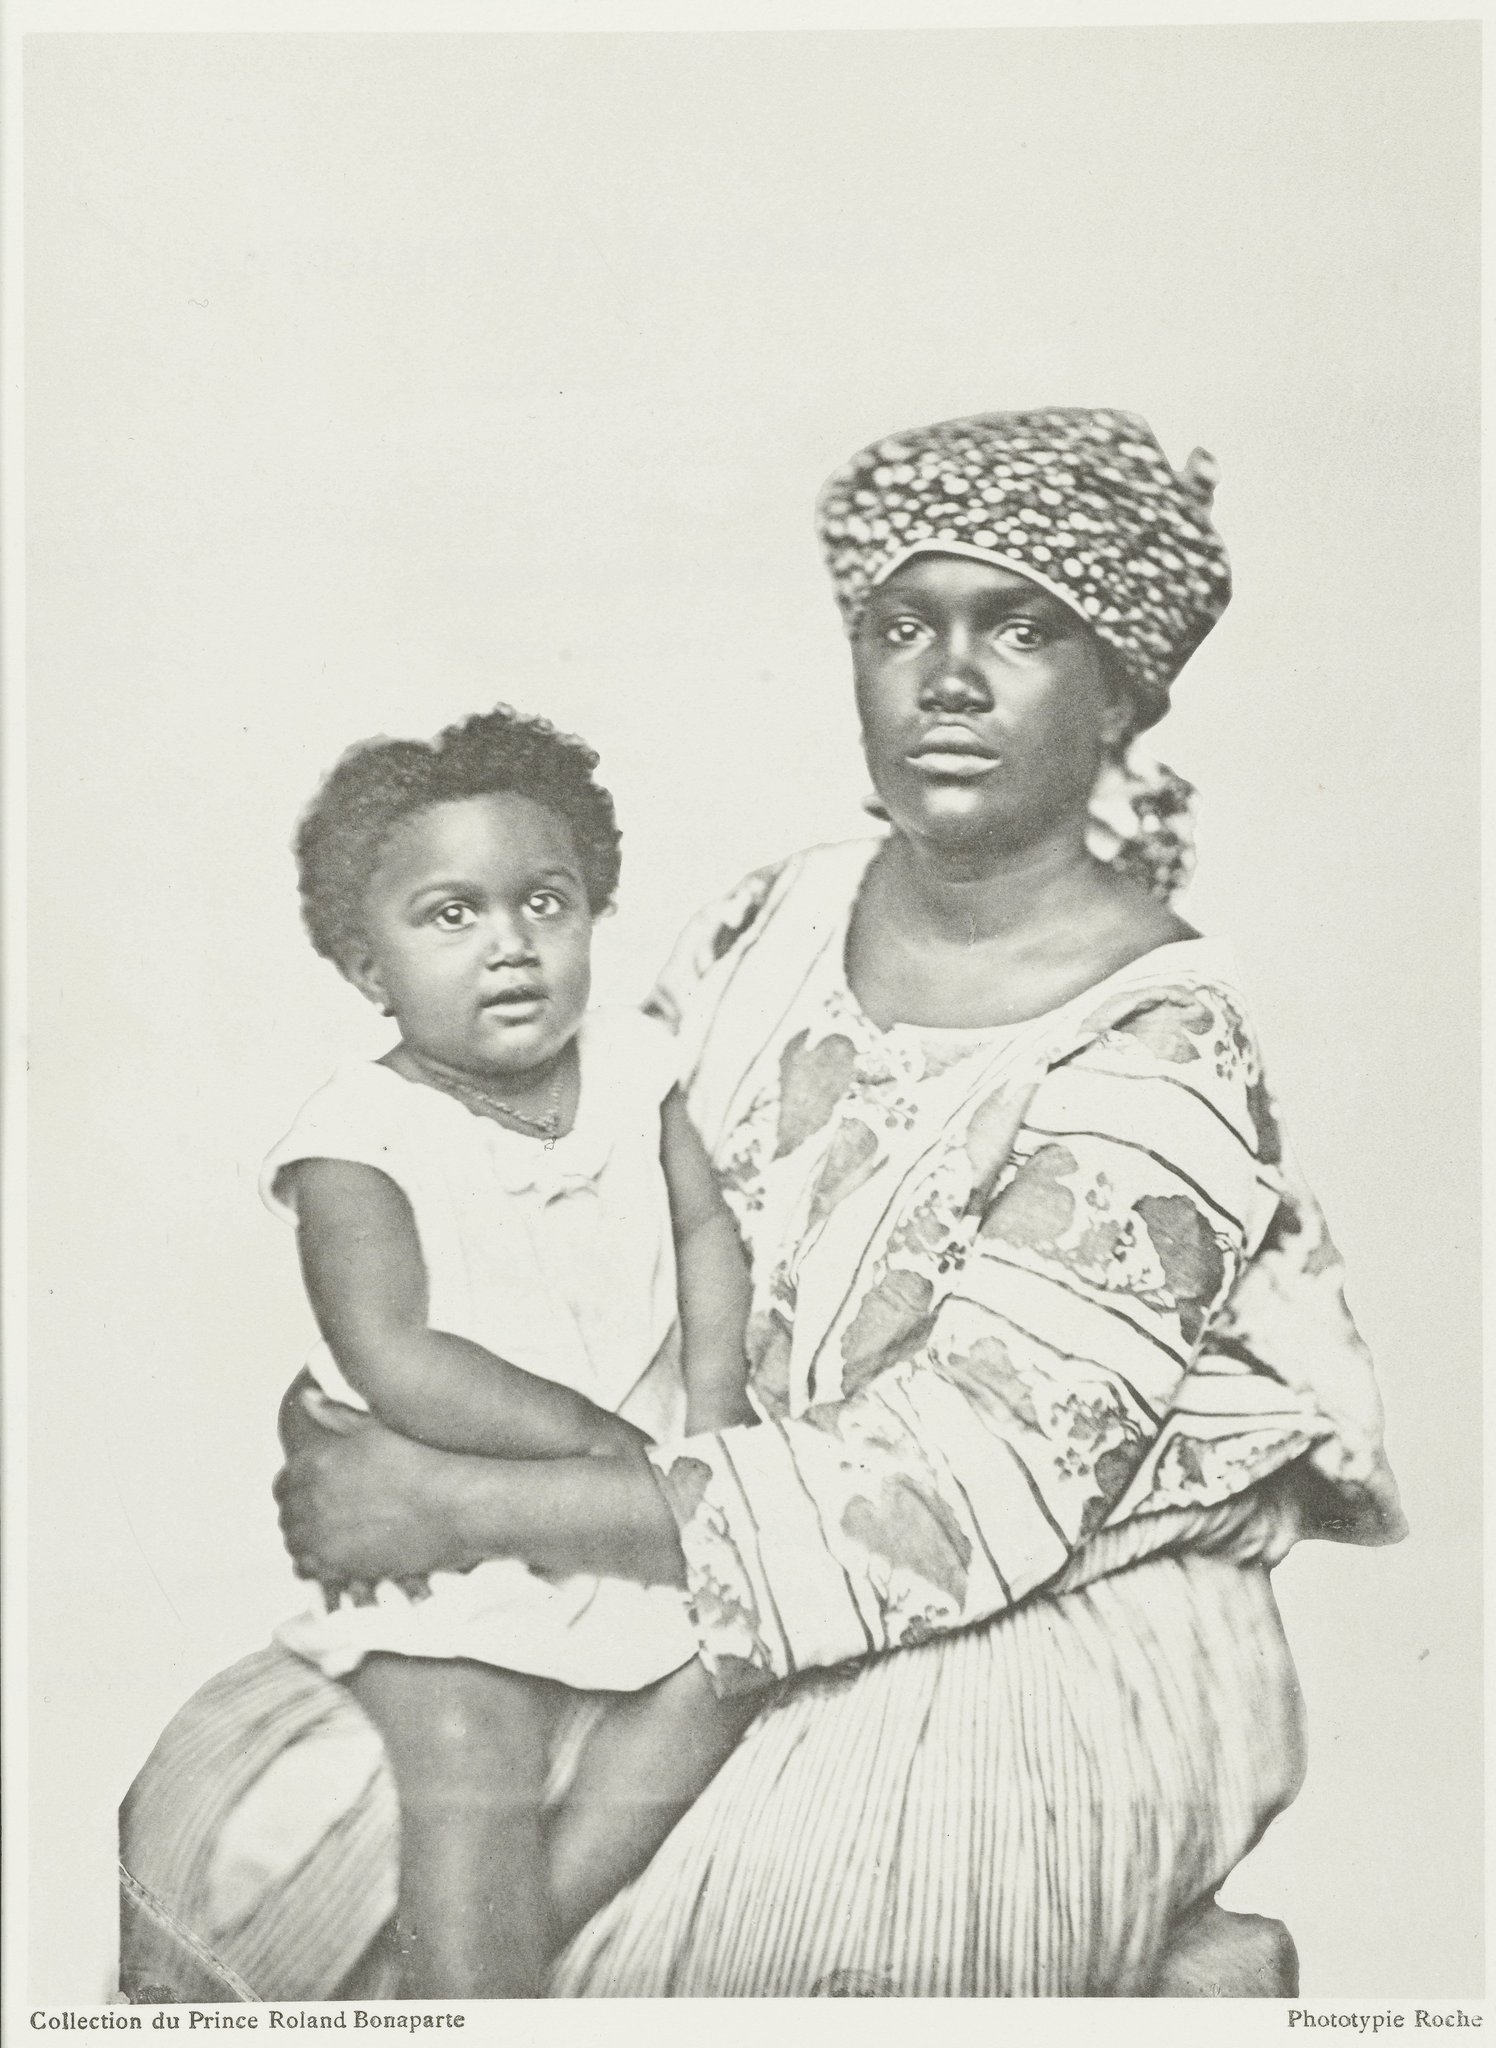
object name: page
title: Jacqueline Ricket et sa fille Lina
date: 1883-1884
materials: paper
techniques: photograph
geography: amsterdam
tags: historical persons, mother and daughter(s) (family group), amsterdam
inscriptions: inscription: ‘Collection du Prince Roland Bonaparte/ Phototypie Roche’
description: Portret van Jacqueline Ricket, een Surinaamse vrouw van Afrikaanse oorsprong, met Lina, dochter van Jacqueline en een Joodse man, gefotografeerd op de Internationale Koloniale en Uitvoerhandel Tentoonstelling, Amsterdam 1883.